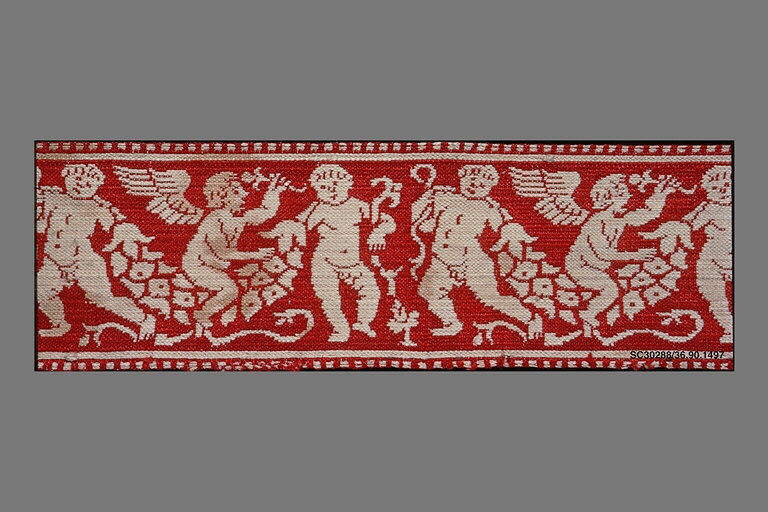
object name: piece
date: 1501-1700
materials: silk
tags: putti